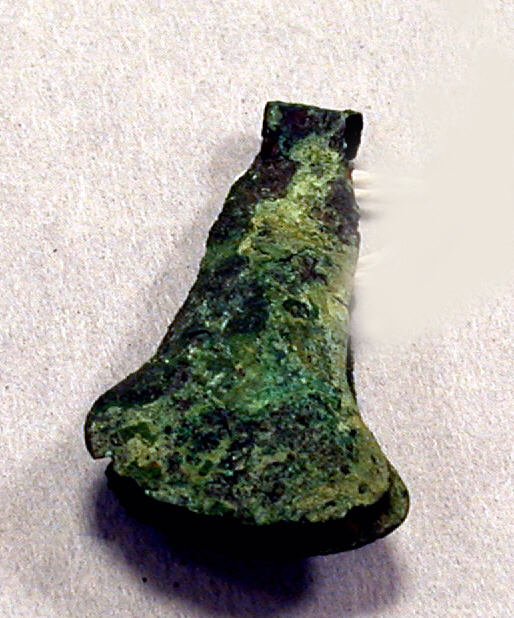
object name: tweezer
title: Hammered Copper Tweezers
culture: peruvian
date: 701-1566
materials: copper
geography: peru